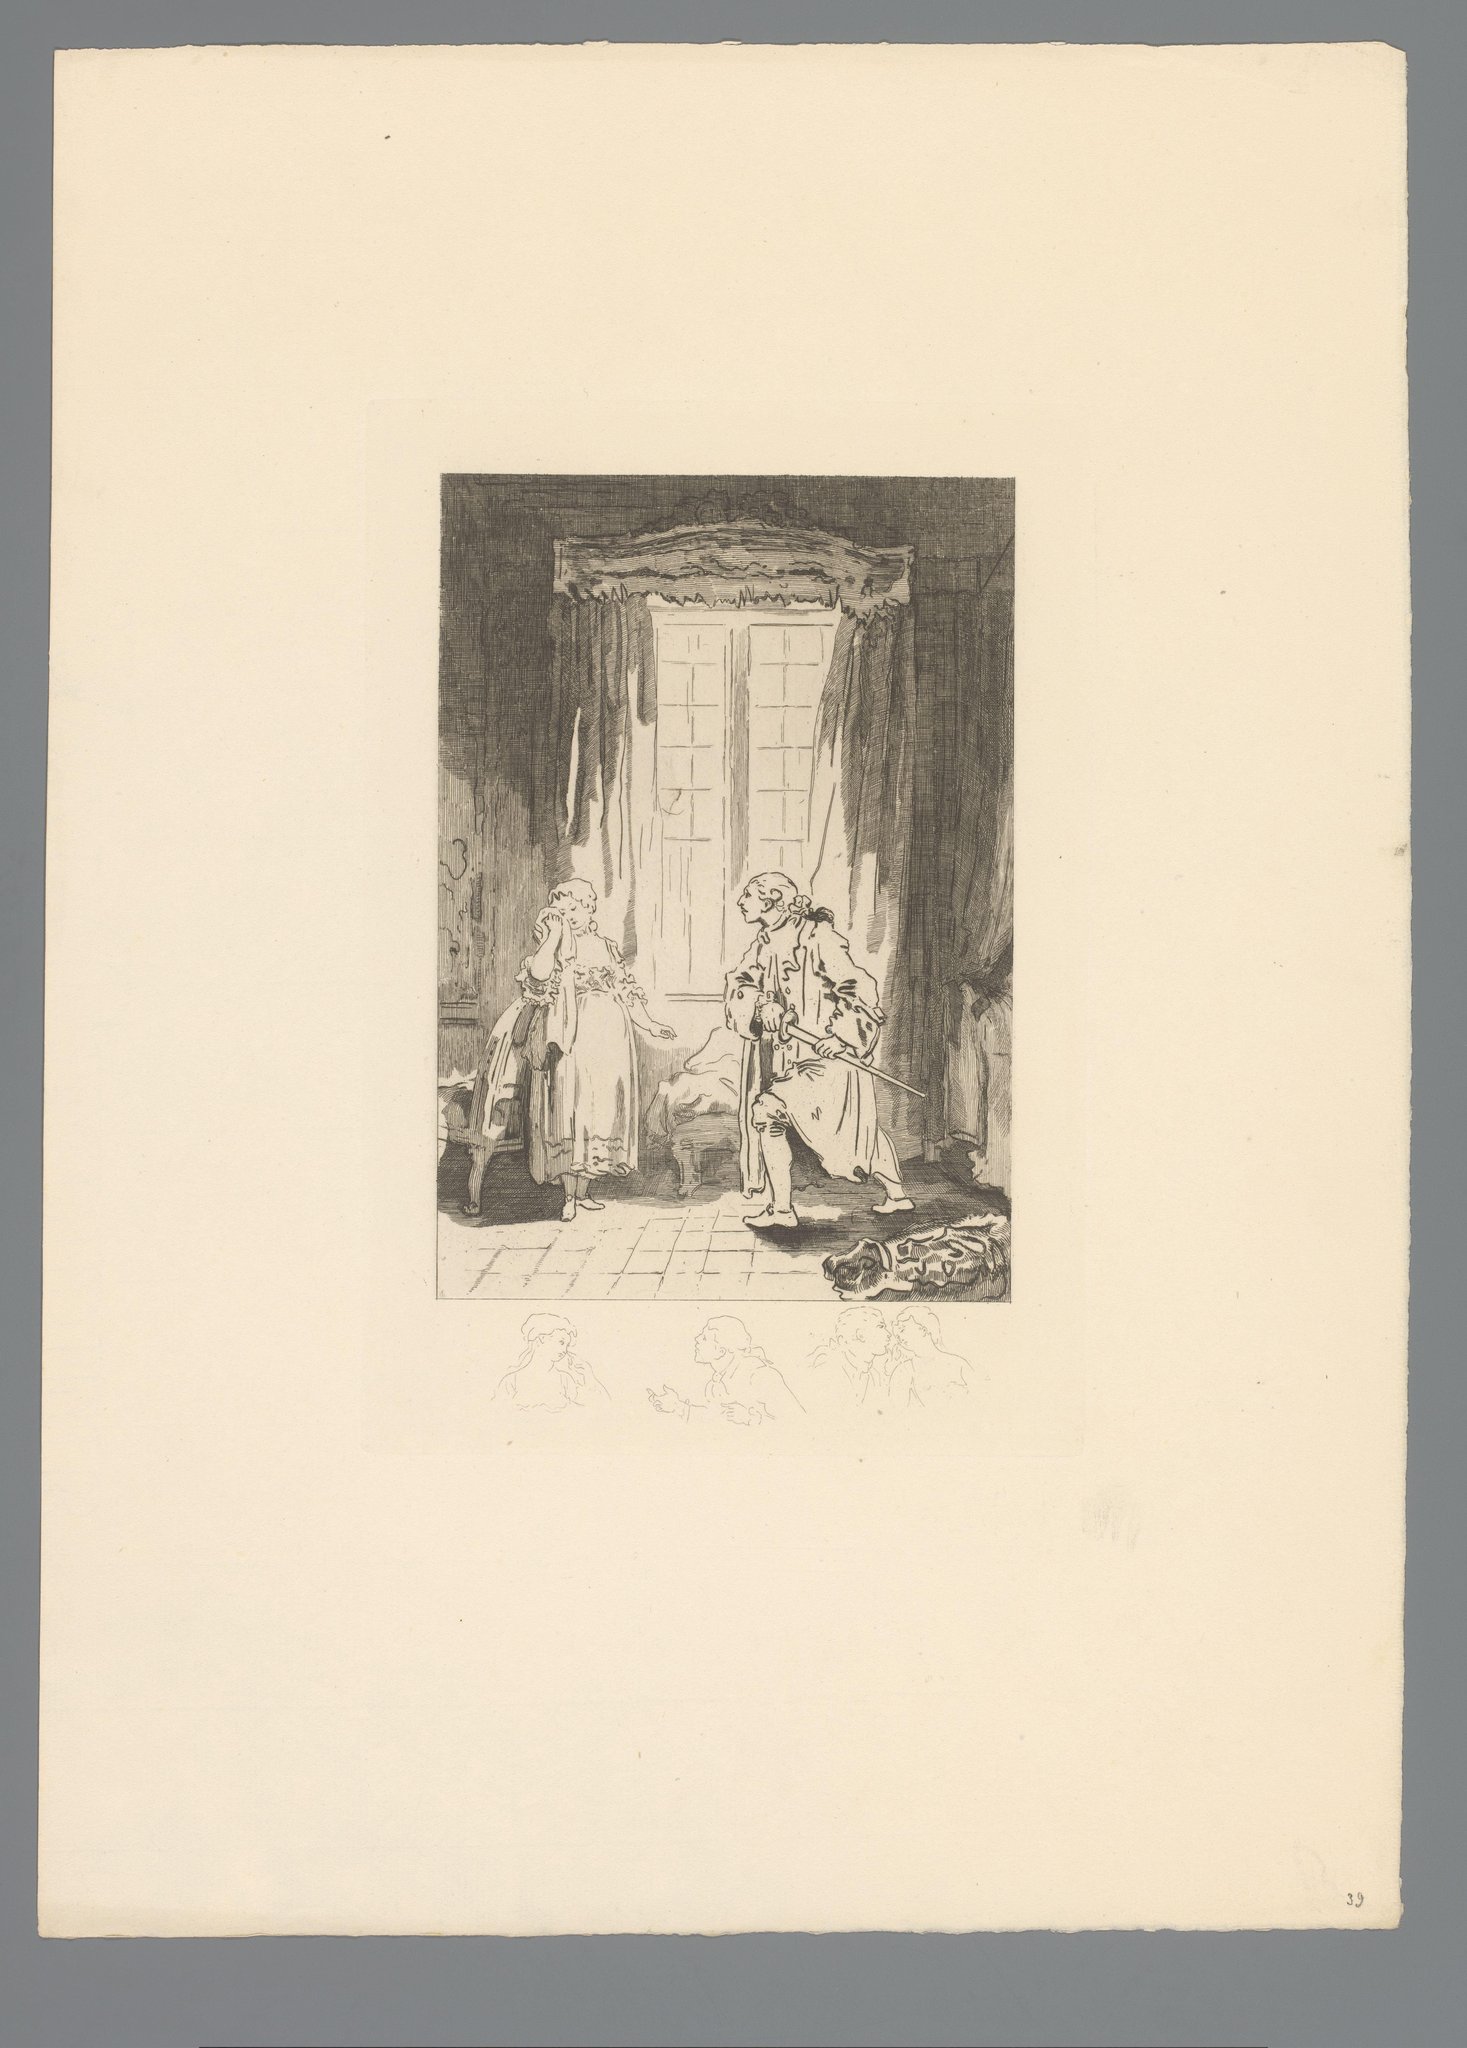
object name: reproduction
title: Figuren uit de verhalen van La Fontaine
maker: Anonymous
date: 1880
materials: paper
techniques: photoaquatint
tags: hacking and thrusting weapons, weeping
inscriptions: collector's mark: Lugt 2228, collector's mark:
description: Martial Potémont maakte etsen naar de tekeningen van Fragonard, die zich bevonden in een manuscript in de collectie van de verzamelaar Eugène Paillet. Rouquette bood hem aan de tekeningen zo exact mogelijk in prent te laten brengen door Martial Potémont: dit resulteerde in een serie van 57 etsen. Vervolgens werden deze gereproduceerd door middel van heliogravure. Deze omslag betreft een editie voor de letter, "Eau forte pure", de 1e staat van 3 waar men uit kon kiezen bij deze serie.